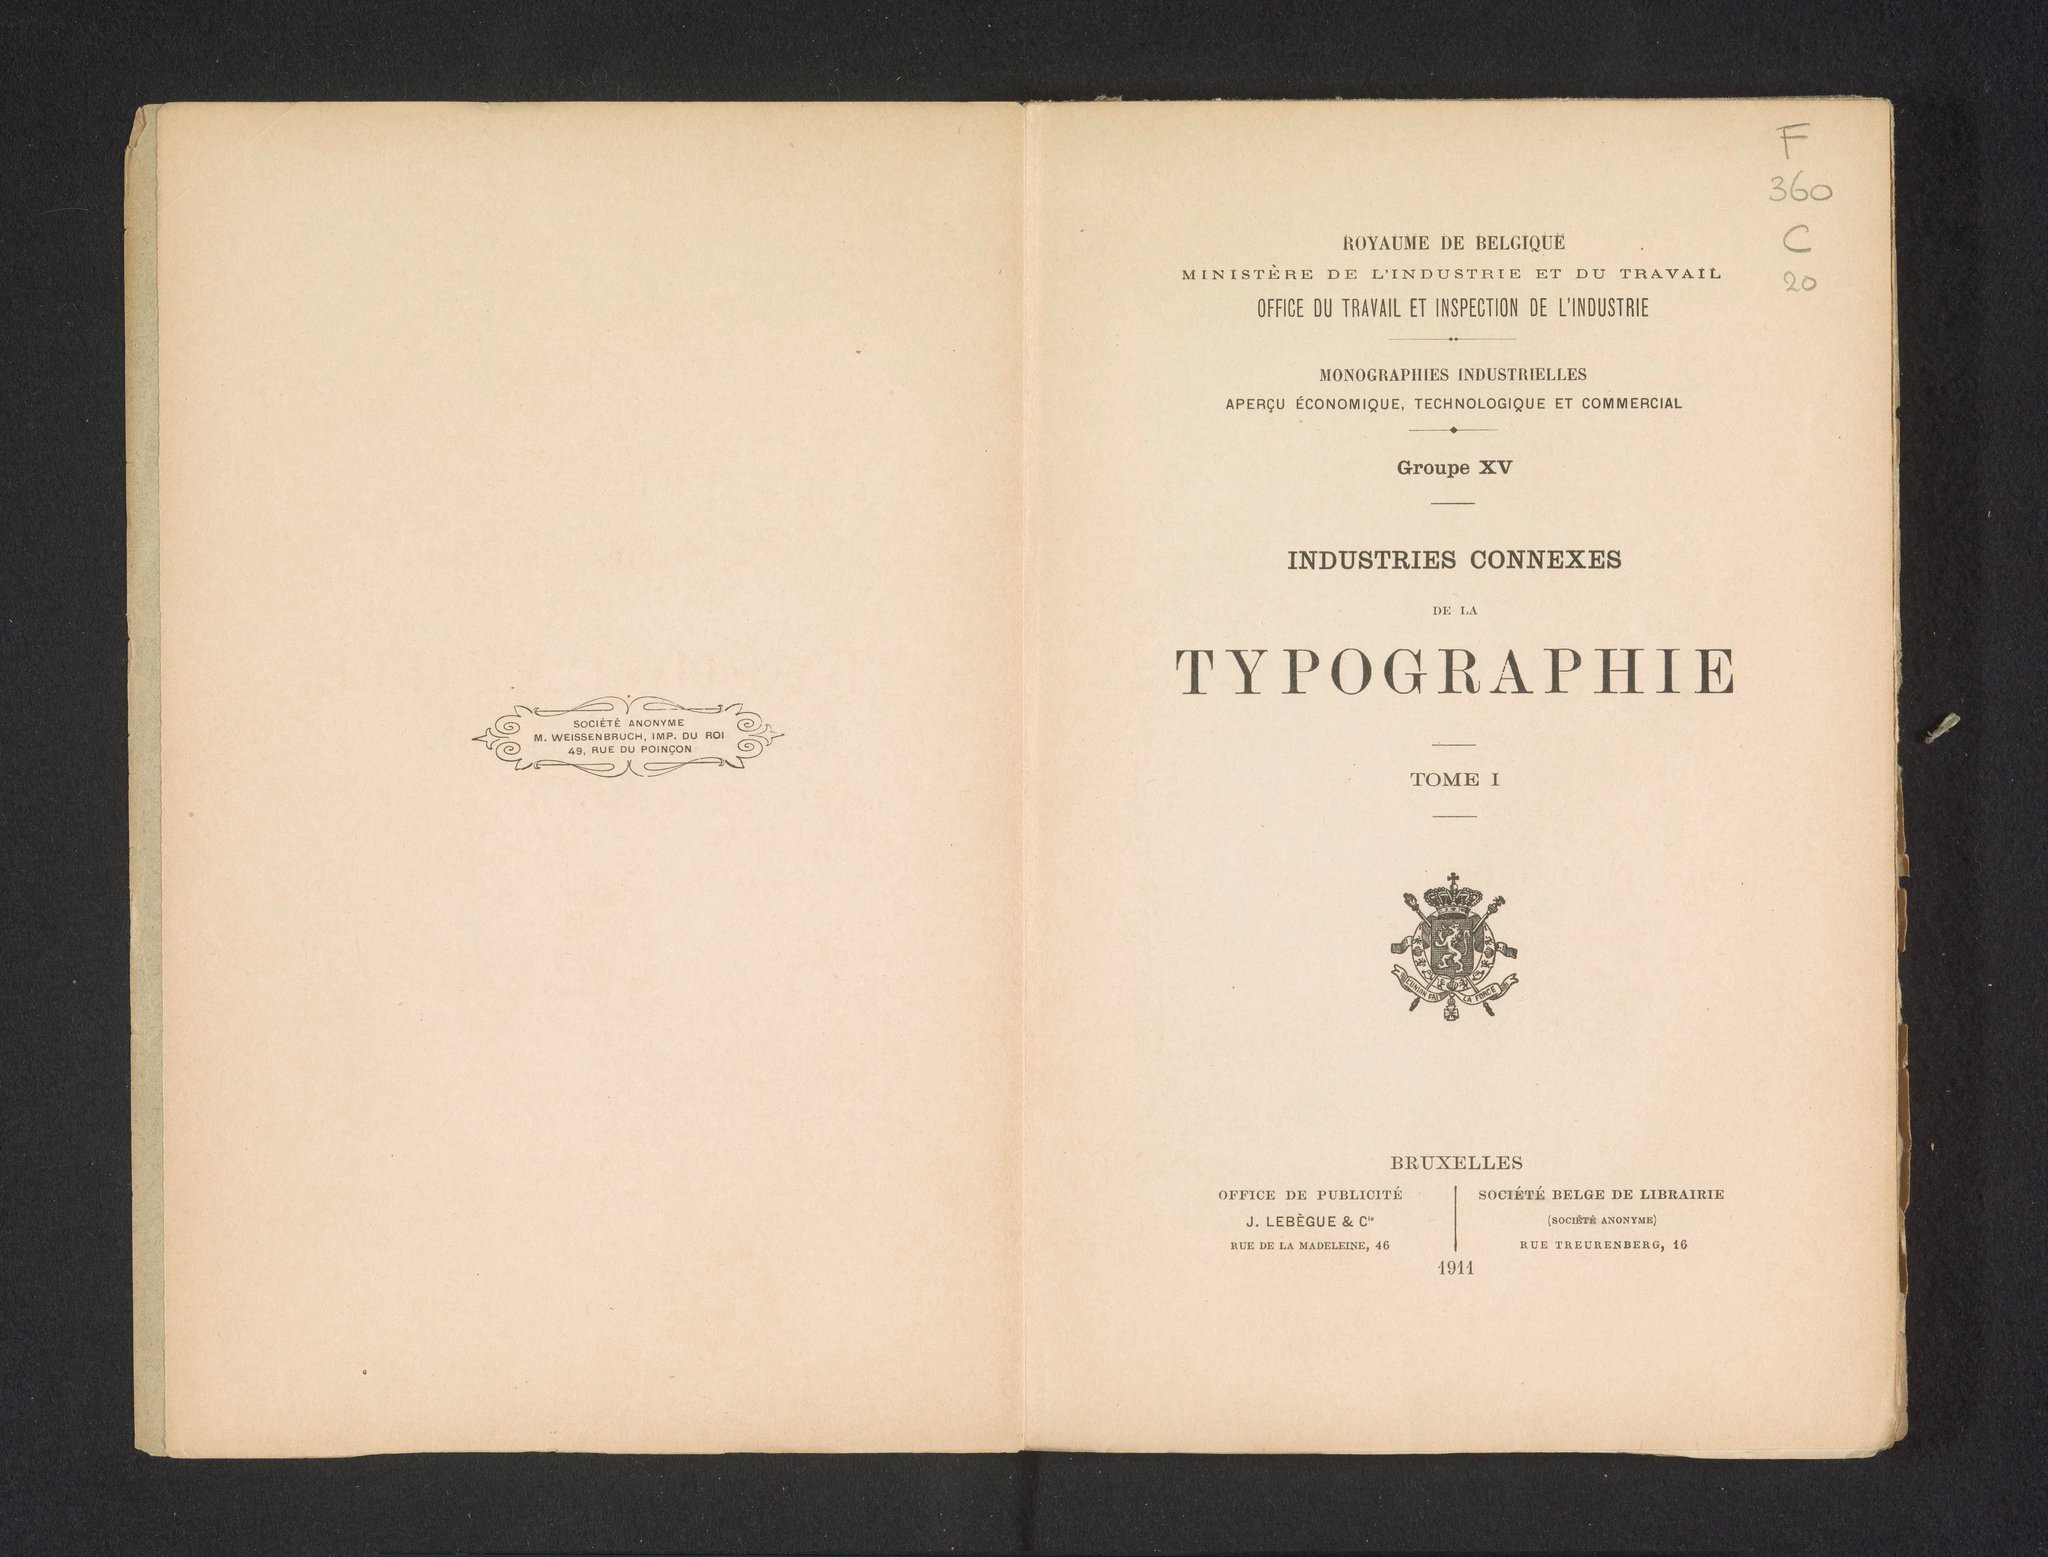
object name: book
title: Industries connexes de la typographie / Royaume de Belgique, Ministère de l'industrie et du travail, Office du travail et inspection de l'industrie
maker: m. weissenbruch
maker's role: printer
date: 1911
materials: paper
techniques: printing, engraving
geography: brussels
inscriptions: annotation: ‘AUG/ 1991’, annotation: ‘Dbl y2711/ XV’